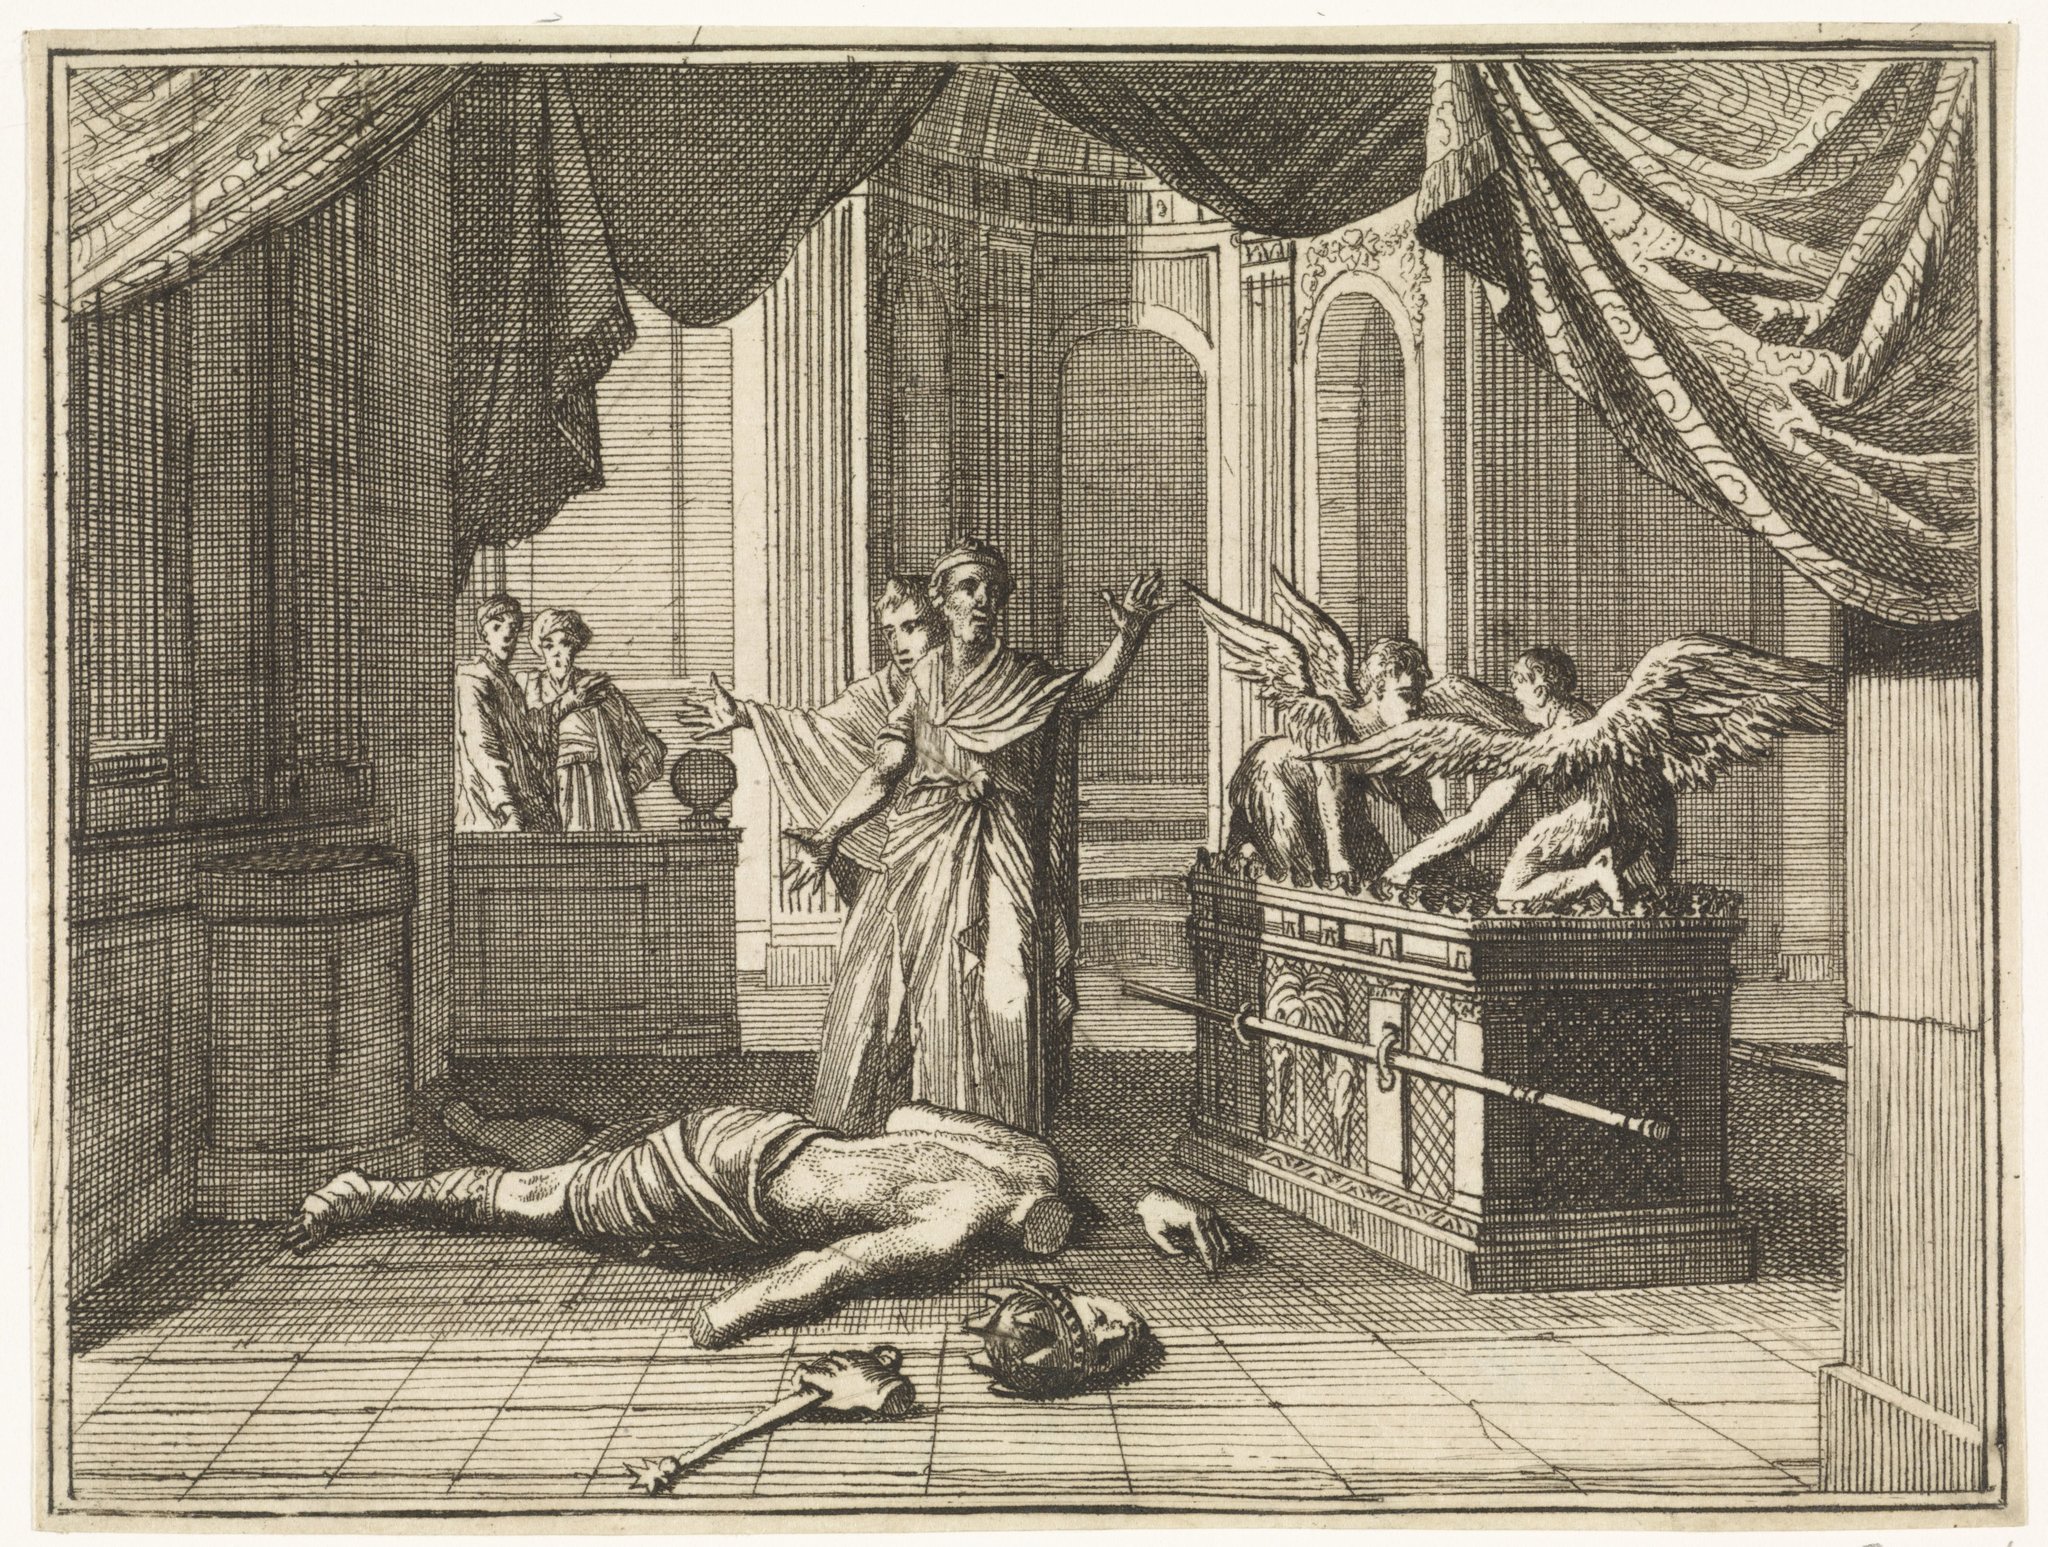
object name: print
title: Ark des Verbonds in de tempel van Dagon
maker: caspar luyken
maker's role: draughtsman, print maker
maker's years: 1672-1708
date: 1712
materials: paper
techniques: etching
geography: amsterdam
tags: the statue of dagon in ashdod falls down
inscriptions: number: ‘96’, collector's mark: Lugt 2228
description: Illustratie uit: Luyken, Jan. De schriftuurlyke geschiedenissen en gelykenissen van het Oude en Nieuwe Verbond, 2 delen. Amsterdam: Wed. Pieter Arentsz II en Cornelis van der Sys, 1712, dl. I.